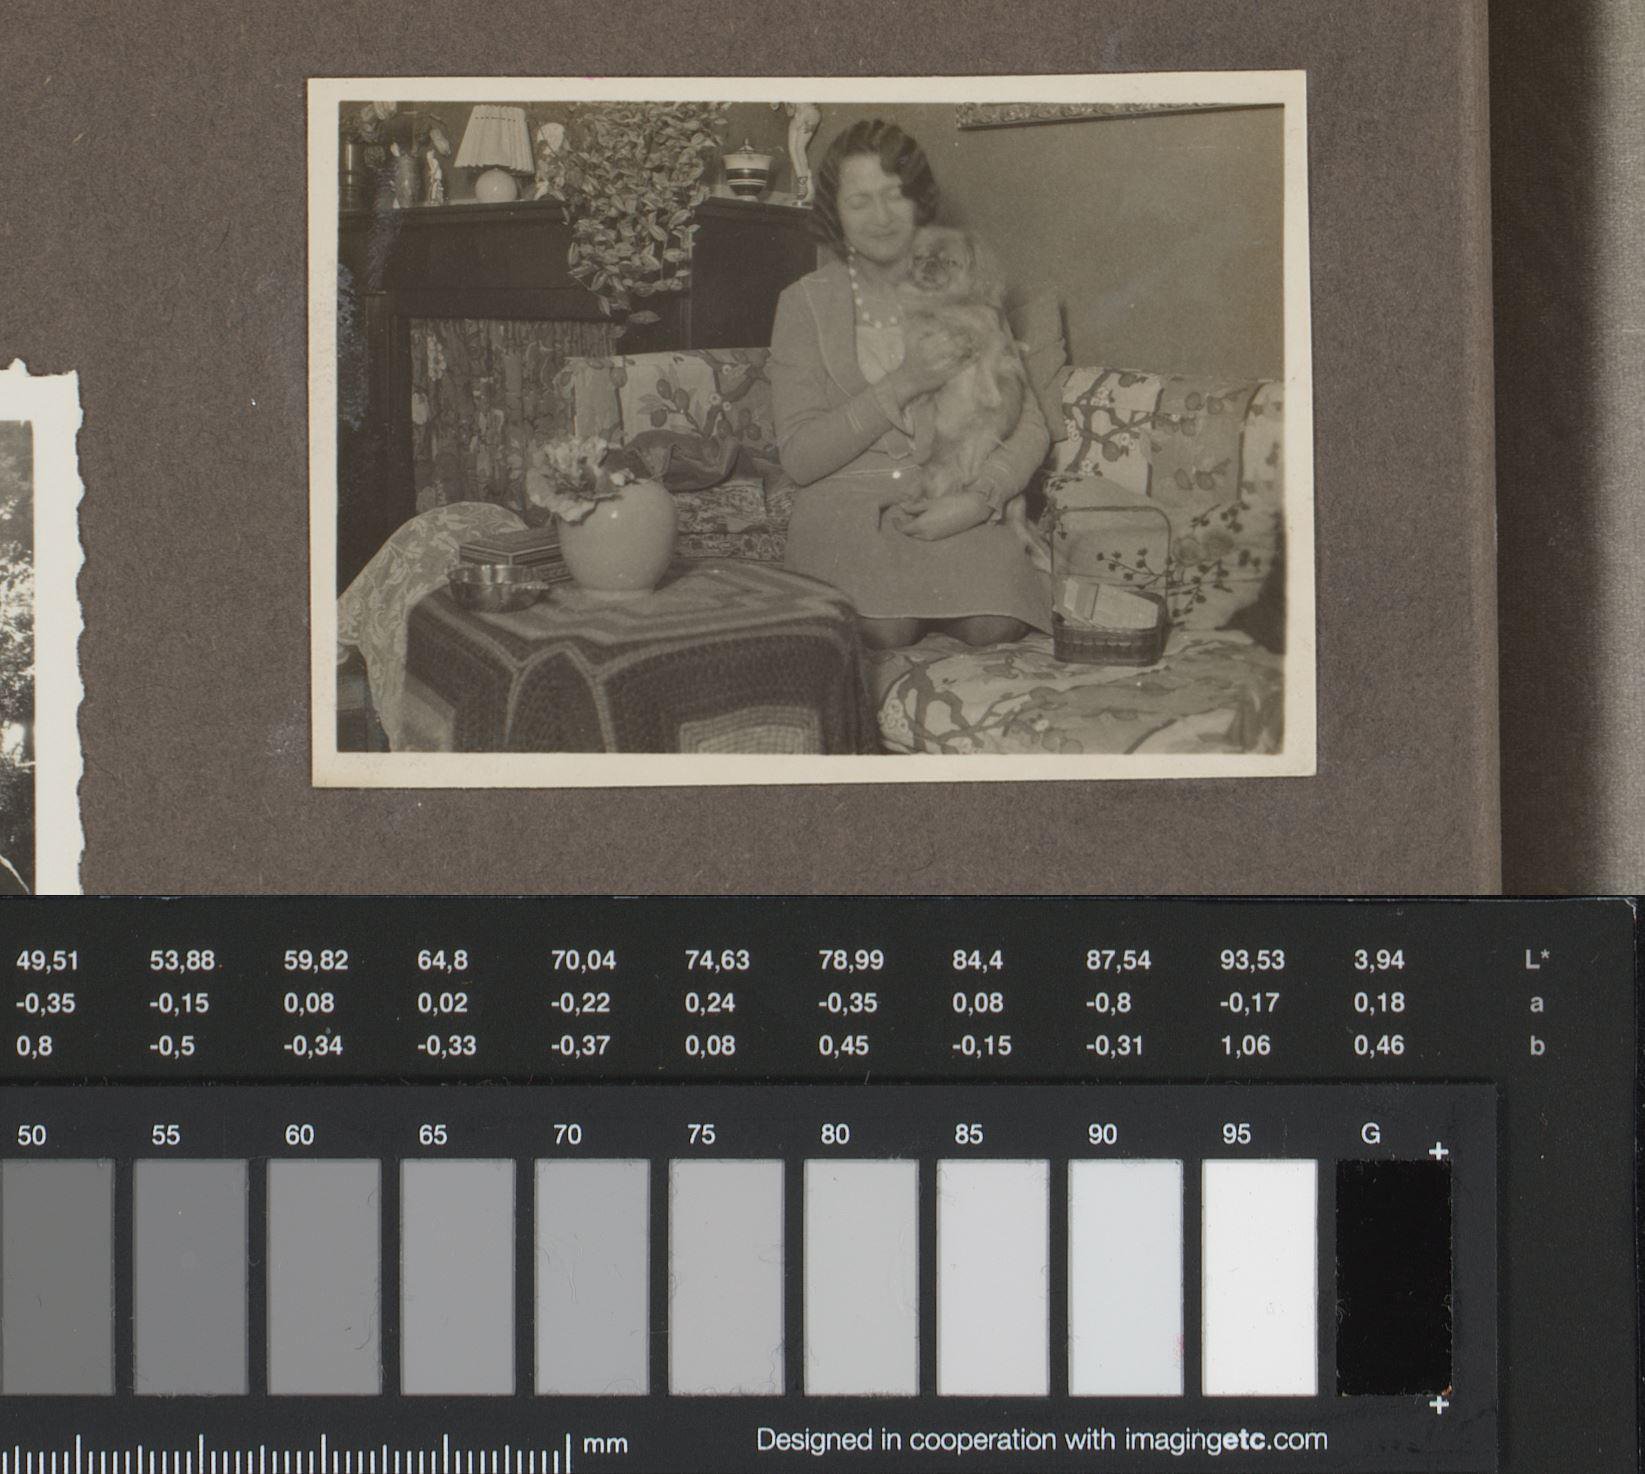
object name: photograph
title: Wilhelmina van Zijll de Jong met hond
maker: Anonymous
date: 1930-1935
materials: paper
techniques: gelatin silver print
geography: netherlands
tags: wilhelmina van zijll de jong, historical persons - bb - woman, dog, netherlands